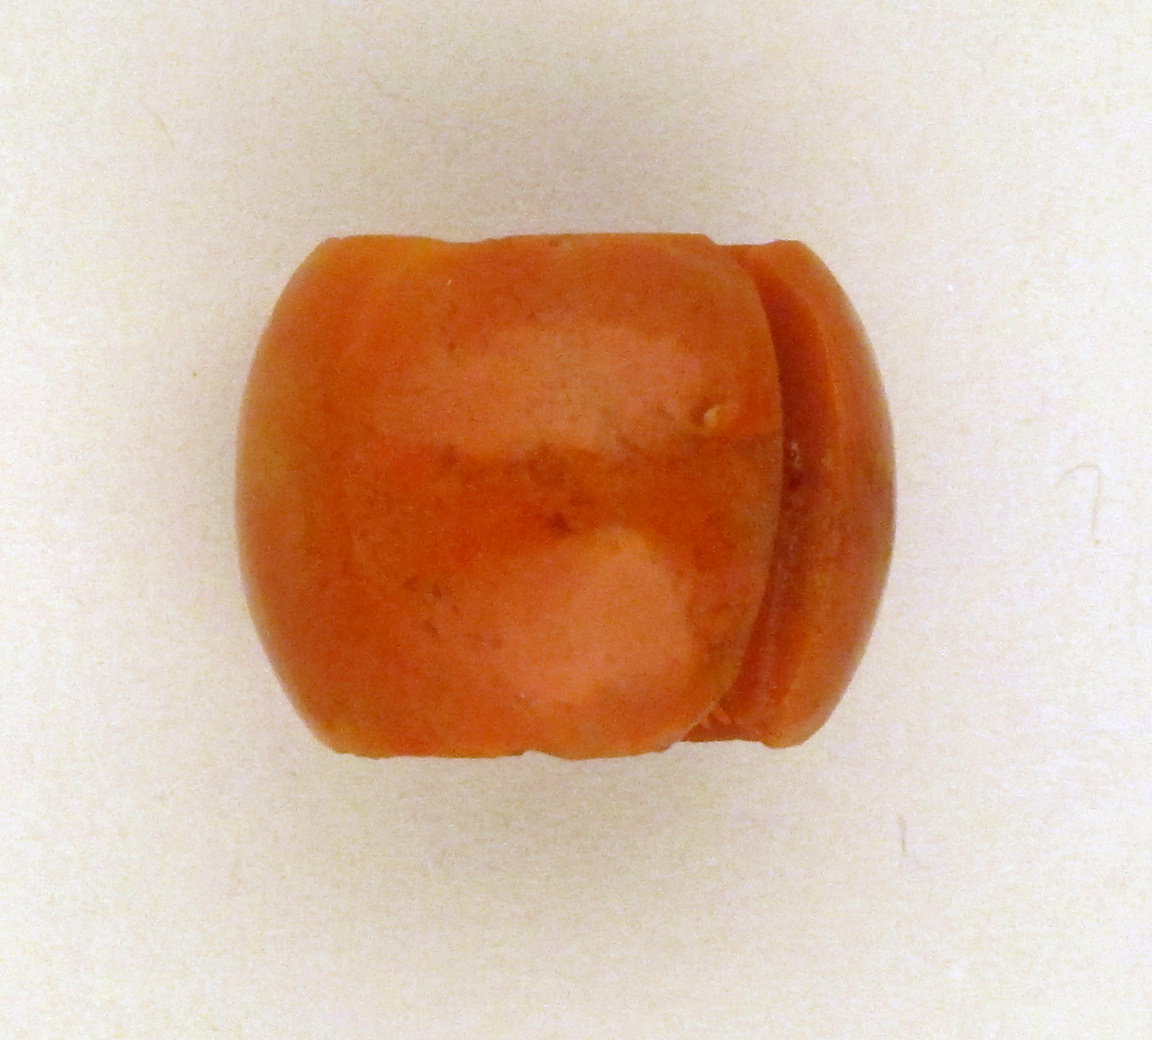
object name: earring, slit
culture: egyptian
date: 1550-1077 BCE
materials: gemstone